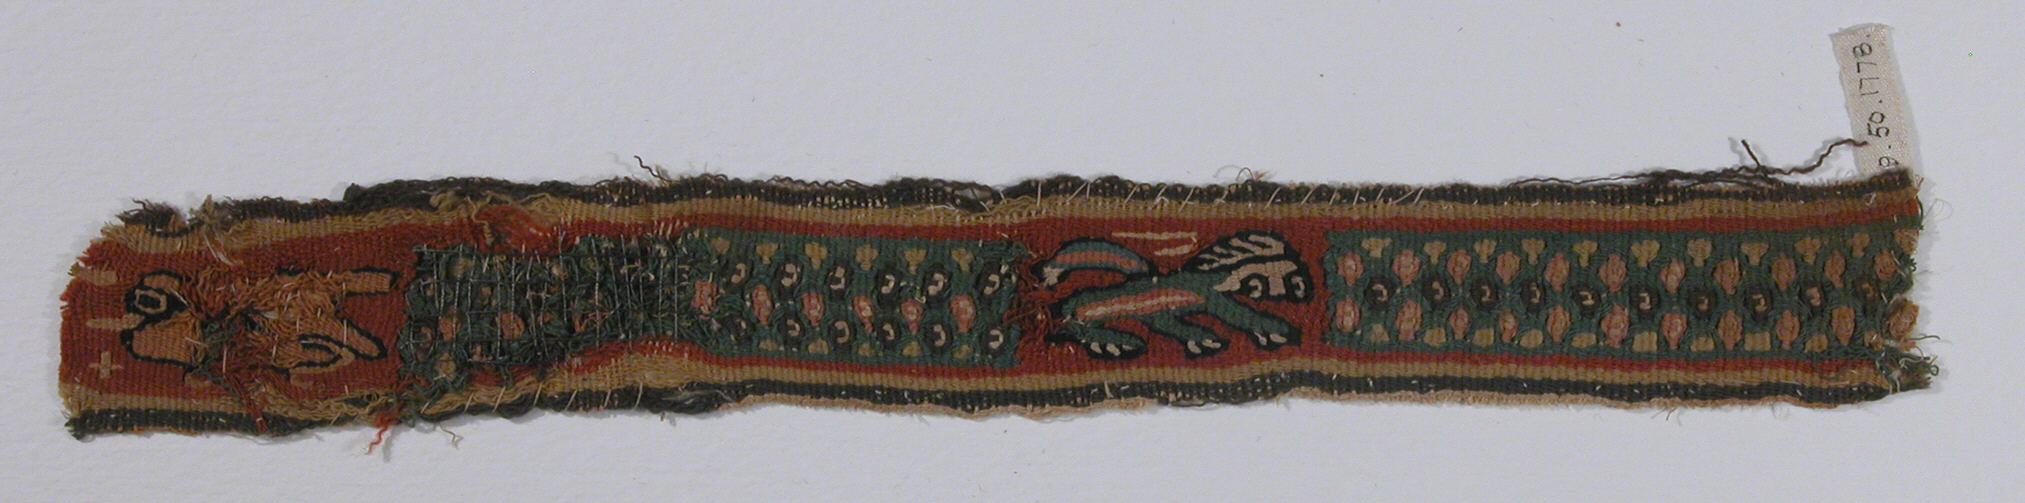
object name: band fragment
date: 501-700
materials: linen, wool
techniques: weave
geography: egypt